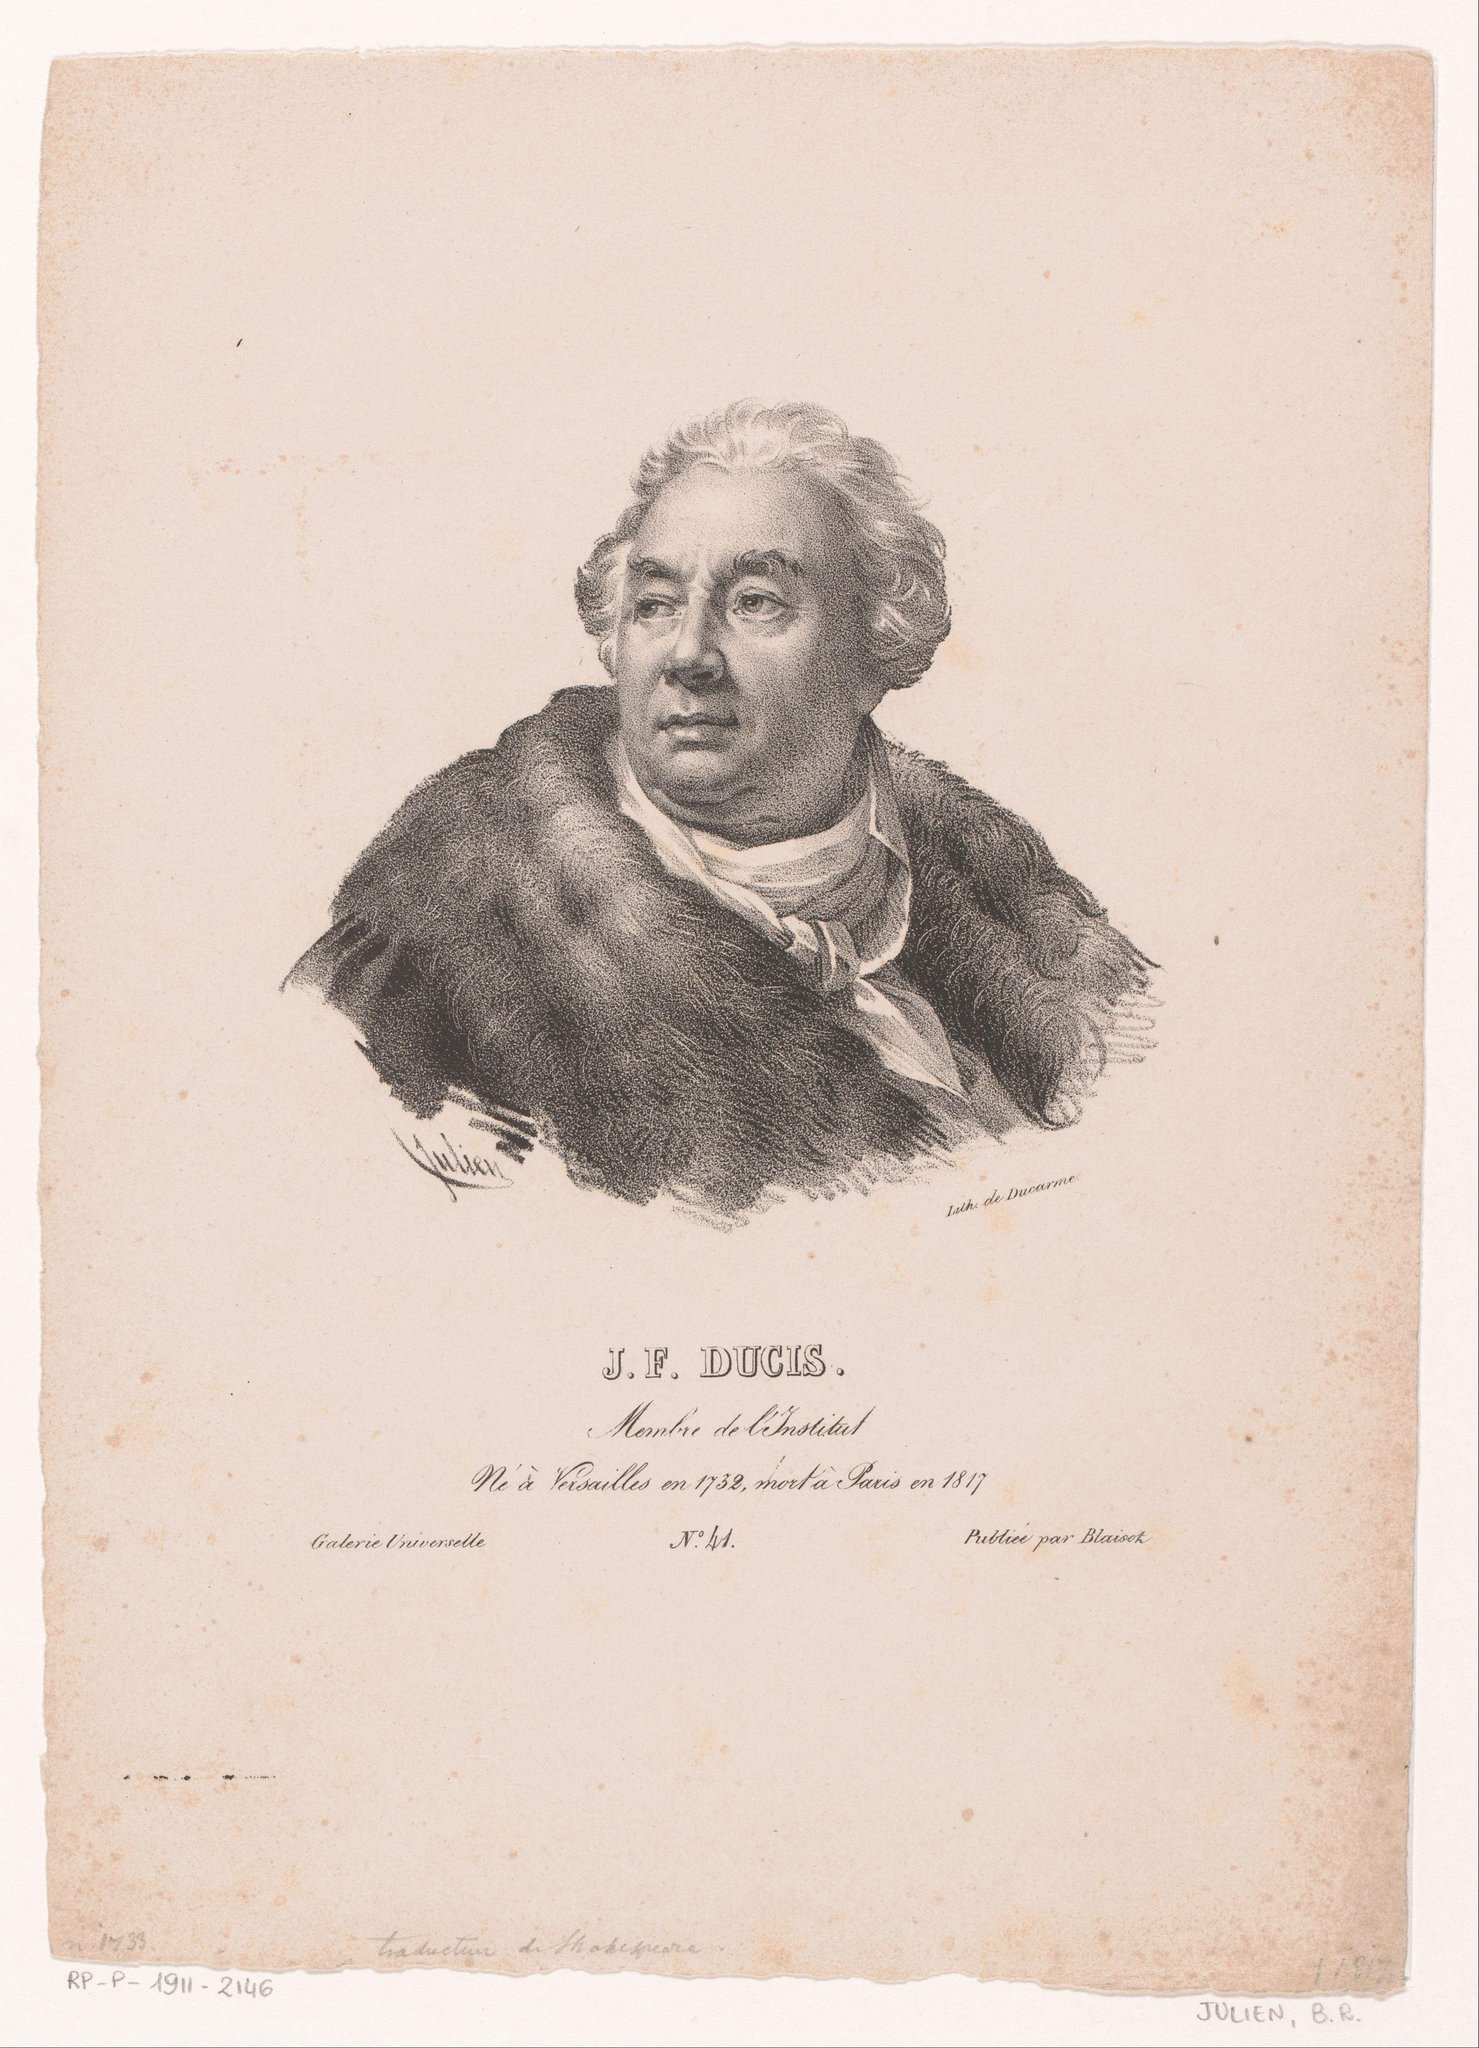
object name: print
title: J.F. Ducis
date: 1827-1830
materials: paper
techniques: lithograph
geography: paris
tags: historical persons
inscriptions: collector's mark: Lugt 2228a